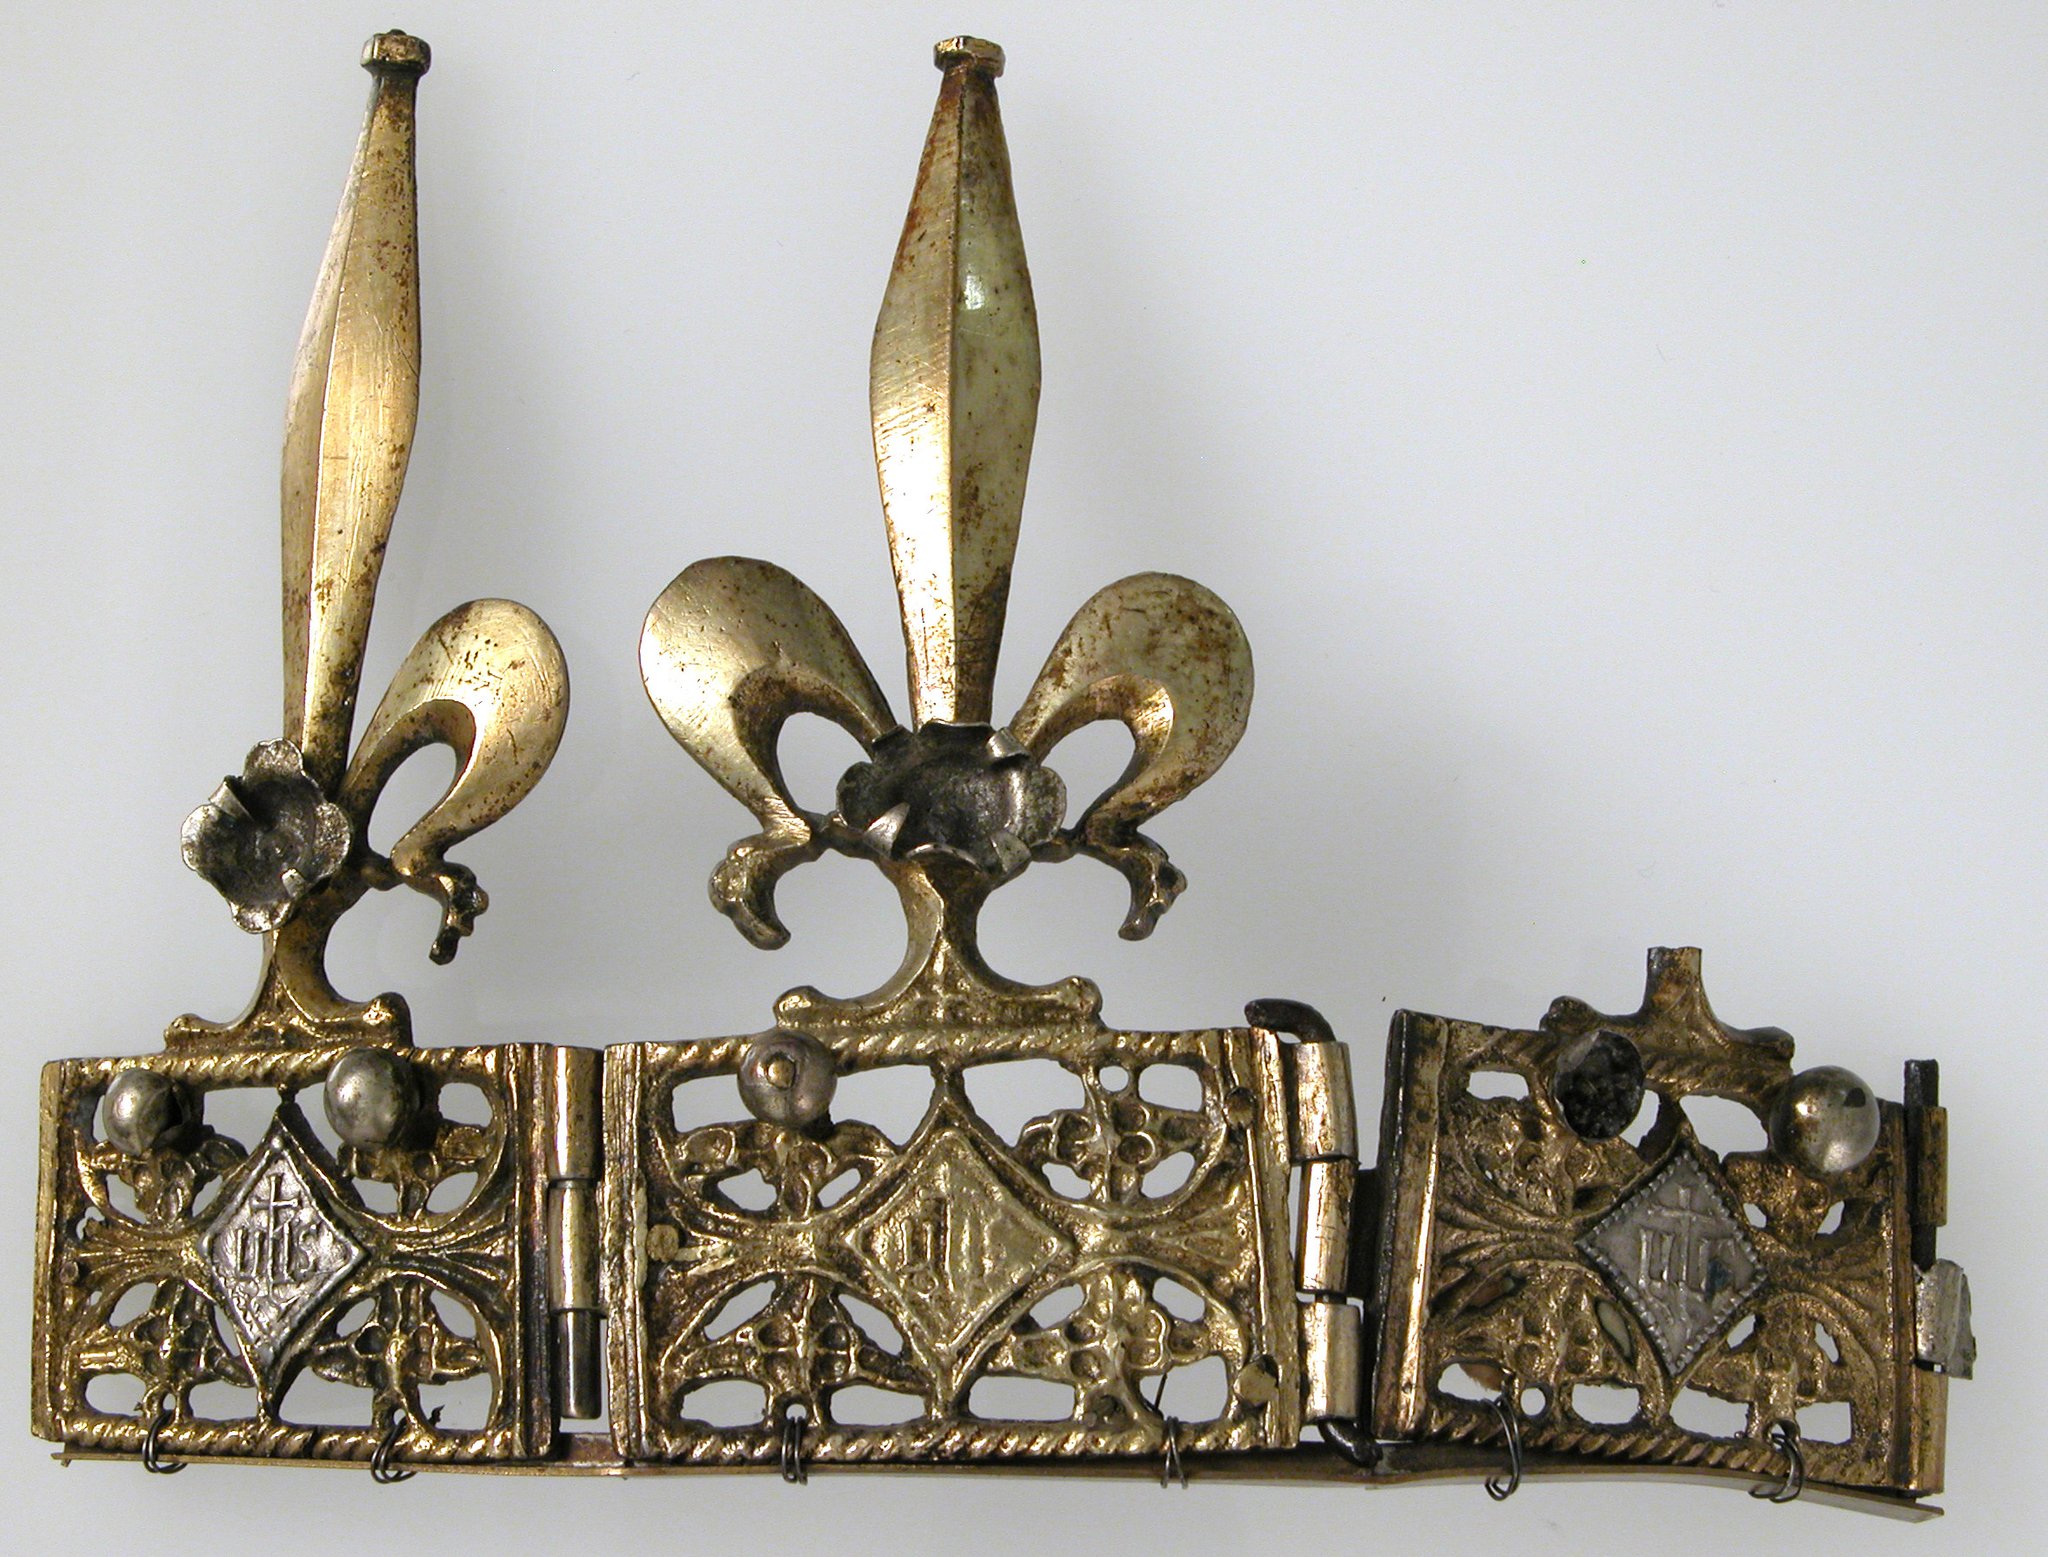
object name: crown fragment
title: Crown, Part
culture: french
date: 1301-1400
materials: copper gilt, silver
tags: crowns